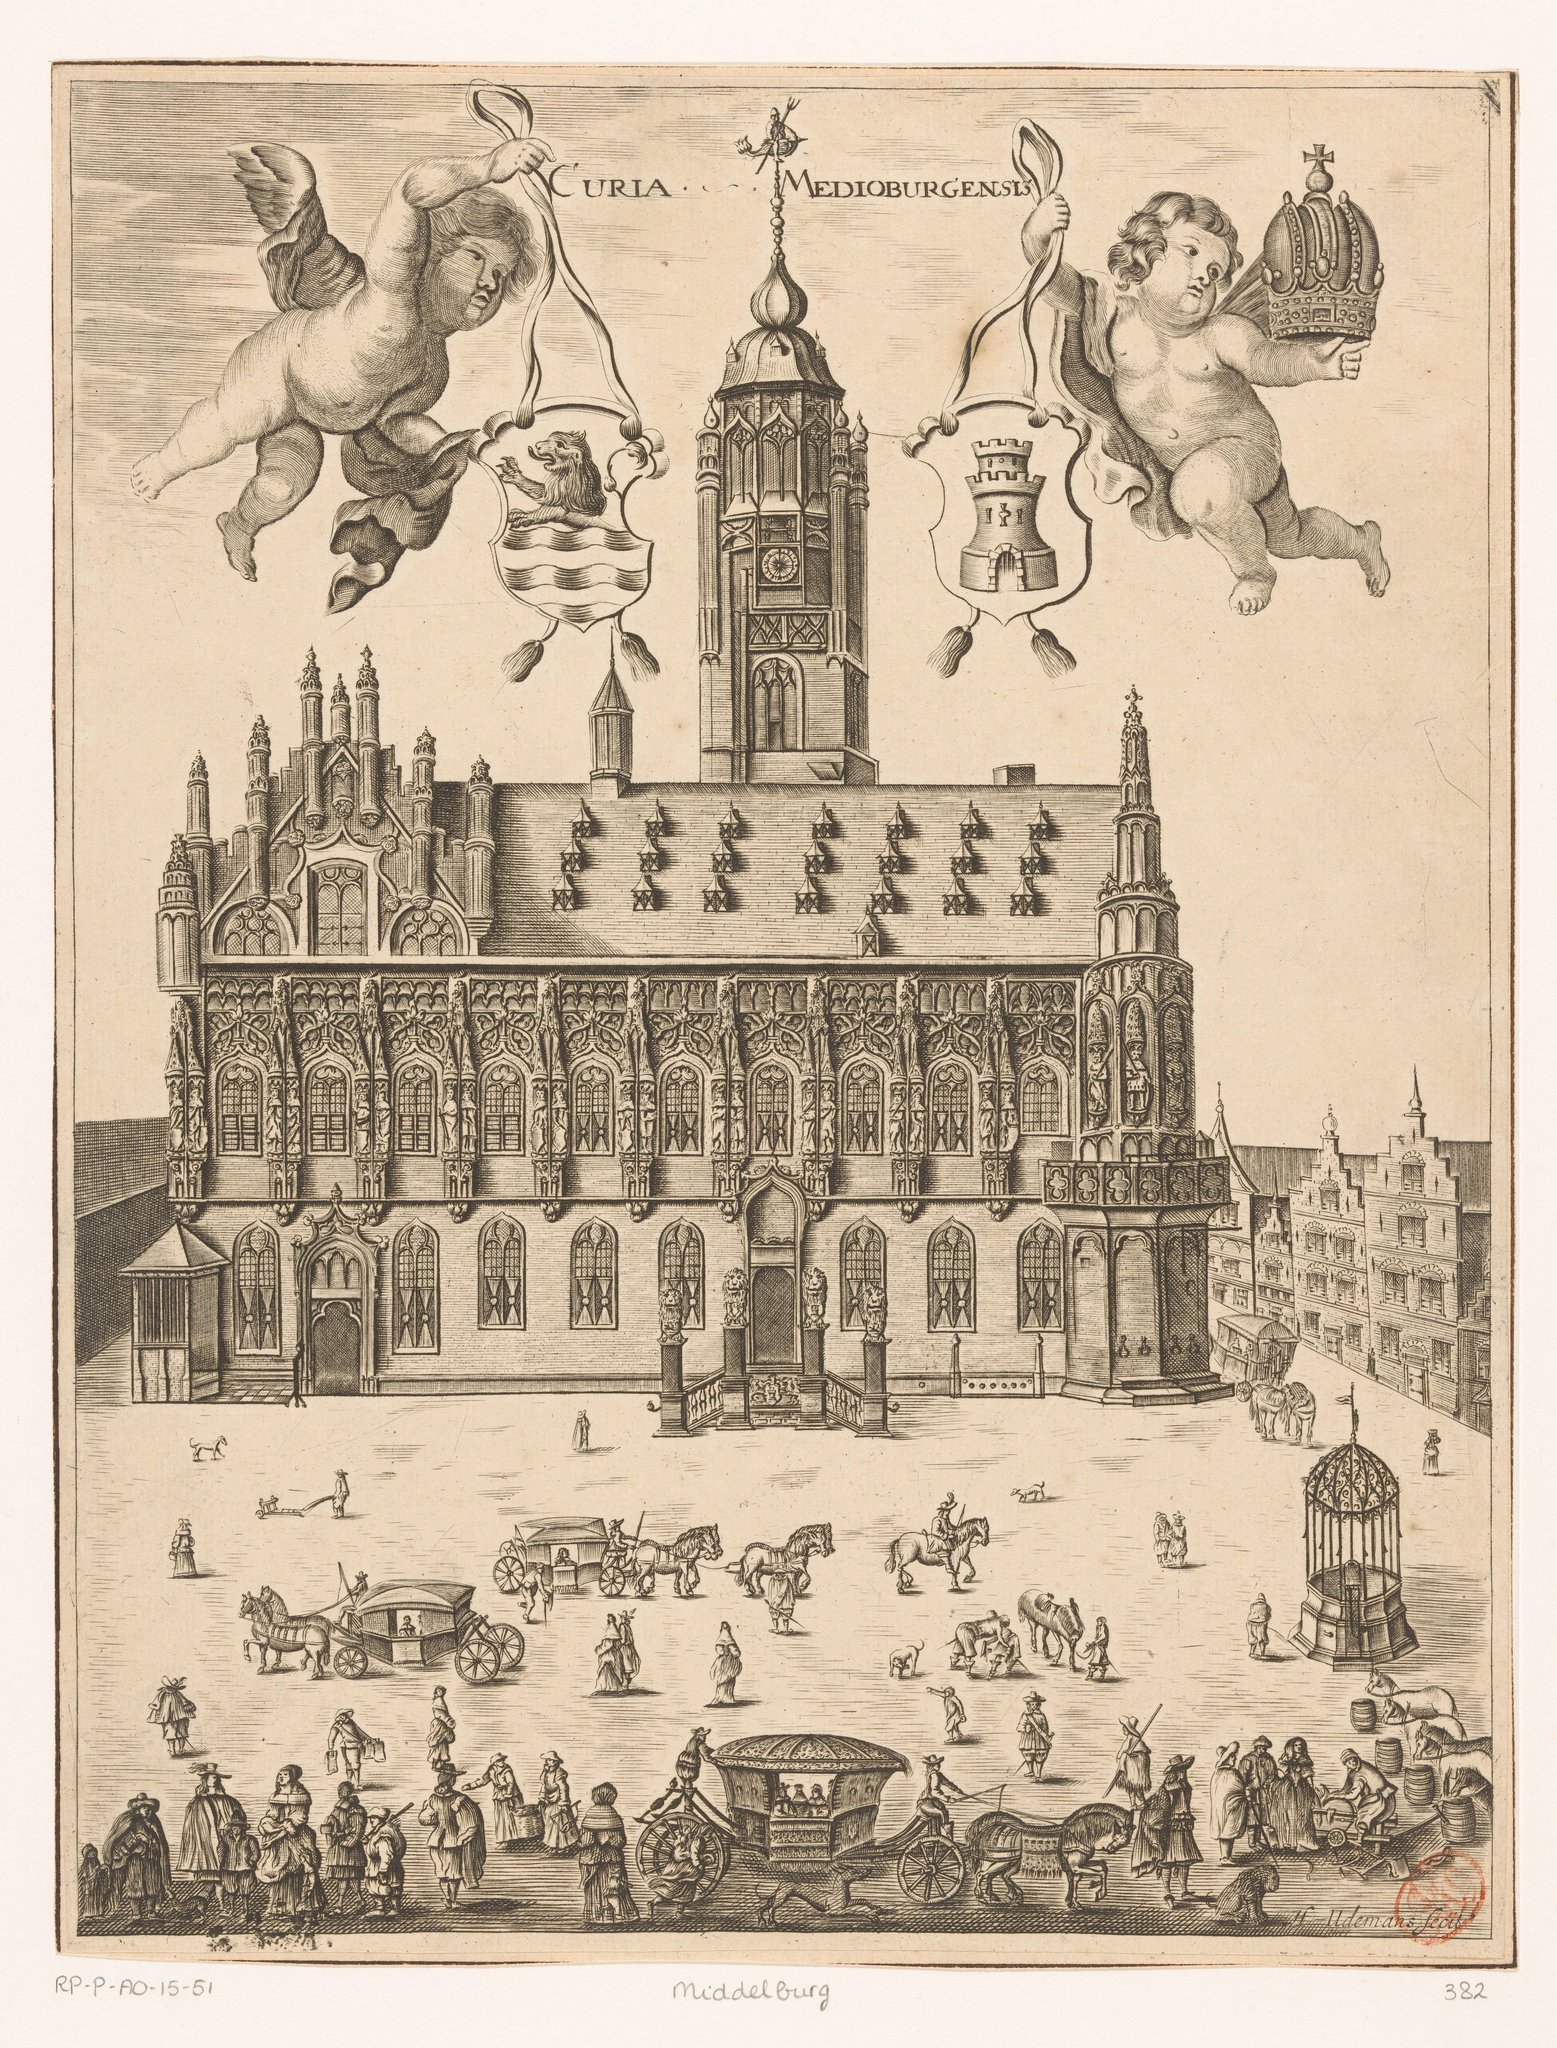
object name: print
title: Gezicht op het stadhuis van Middelburg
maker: hendrik udemans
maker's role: print maker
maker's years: 1622-1659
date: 1647-1659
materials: paper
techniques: engraving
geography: zeeland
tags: coat of arms (as symbol of the state, etc.) (+ city; municipal), townhall, coat of arms (as symbol of the state, etc.) (+ province; provincial)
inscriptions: collector's mark: Lugt 195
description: Gezicht op het stadhuis van Middelburg, gelegen aan de Markt. Boven de titel en twee putti met de wapens van Zeeland en Middelburg. Op de Markt verschillende figuren, koetsen en dieren.